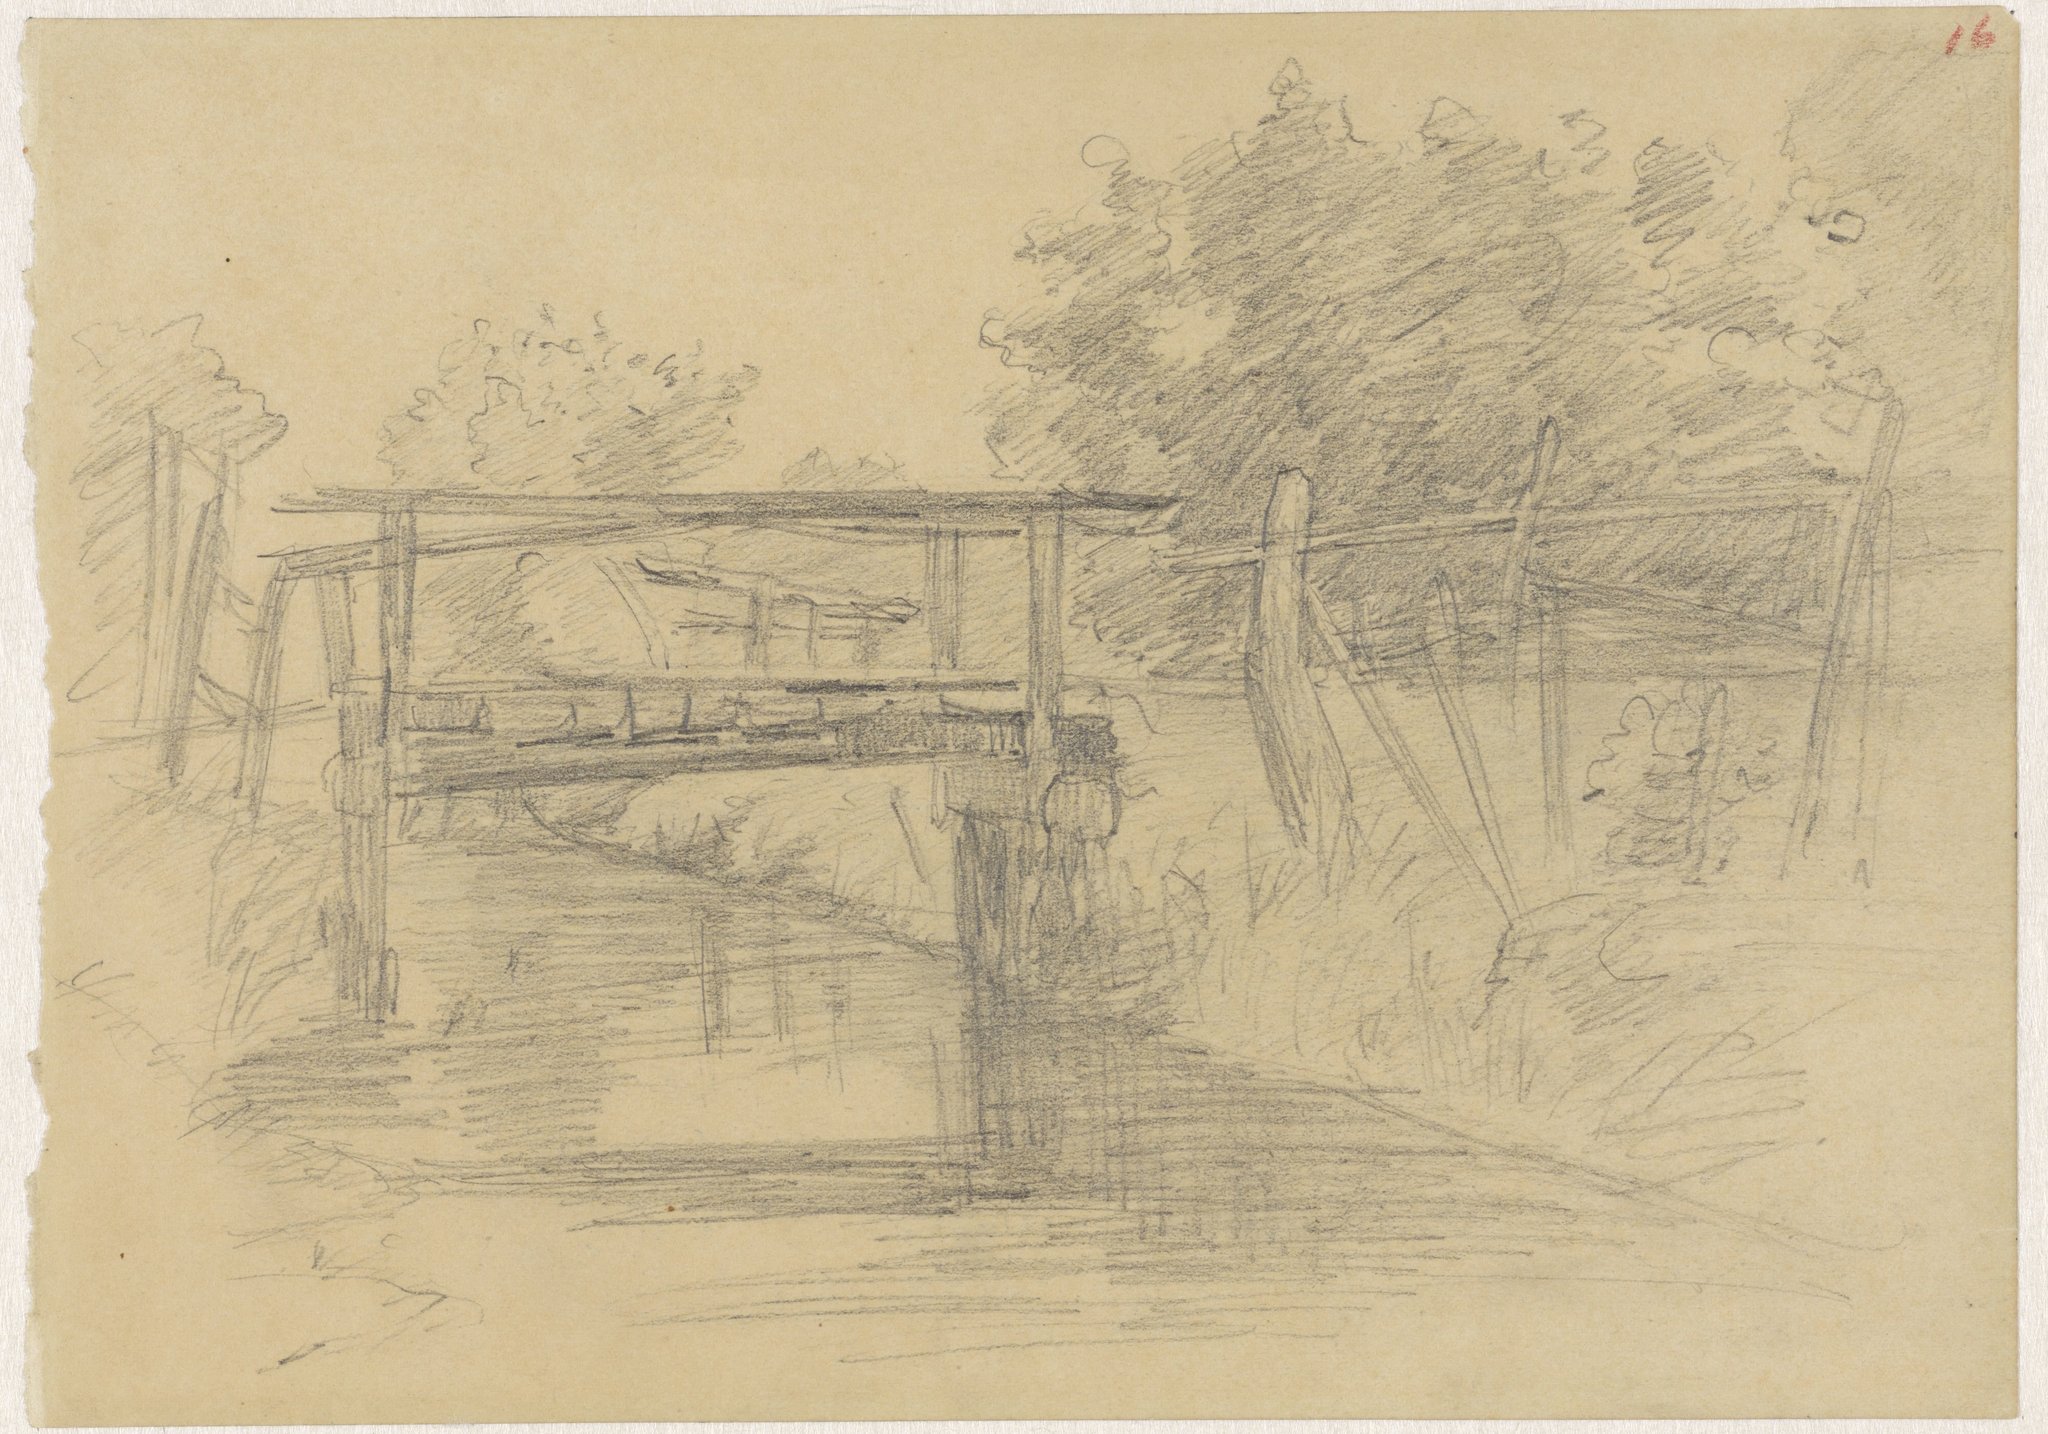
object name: drawing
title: Bruggetje over een sloot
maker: jozef israëls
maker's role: draughtsman, painter, print maker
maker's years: 1824-1911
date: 1834-1911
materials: paper, pencil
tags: bridge